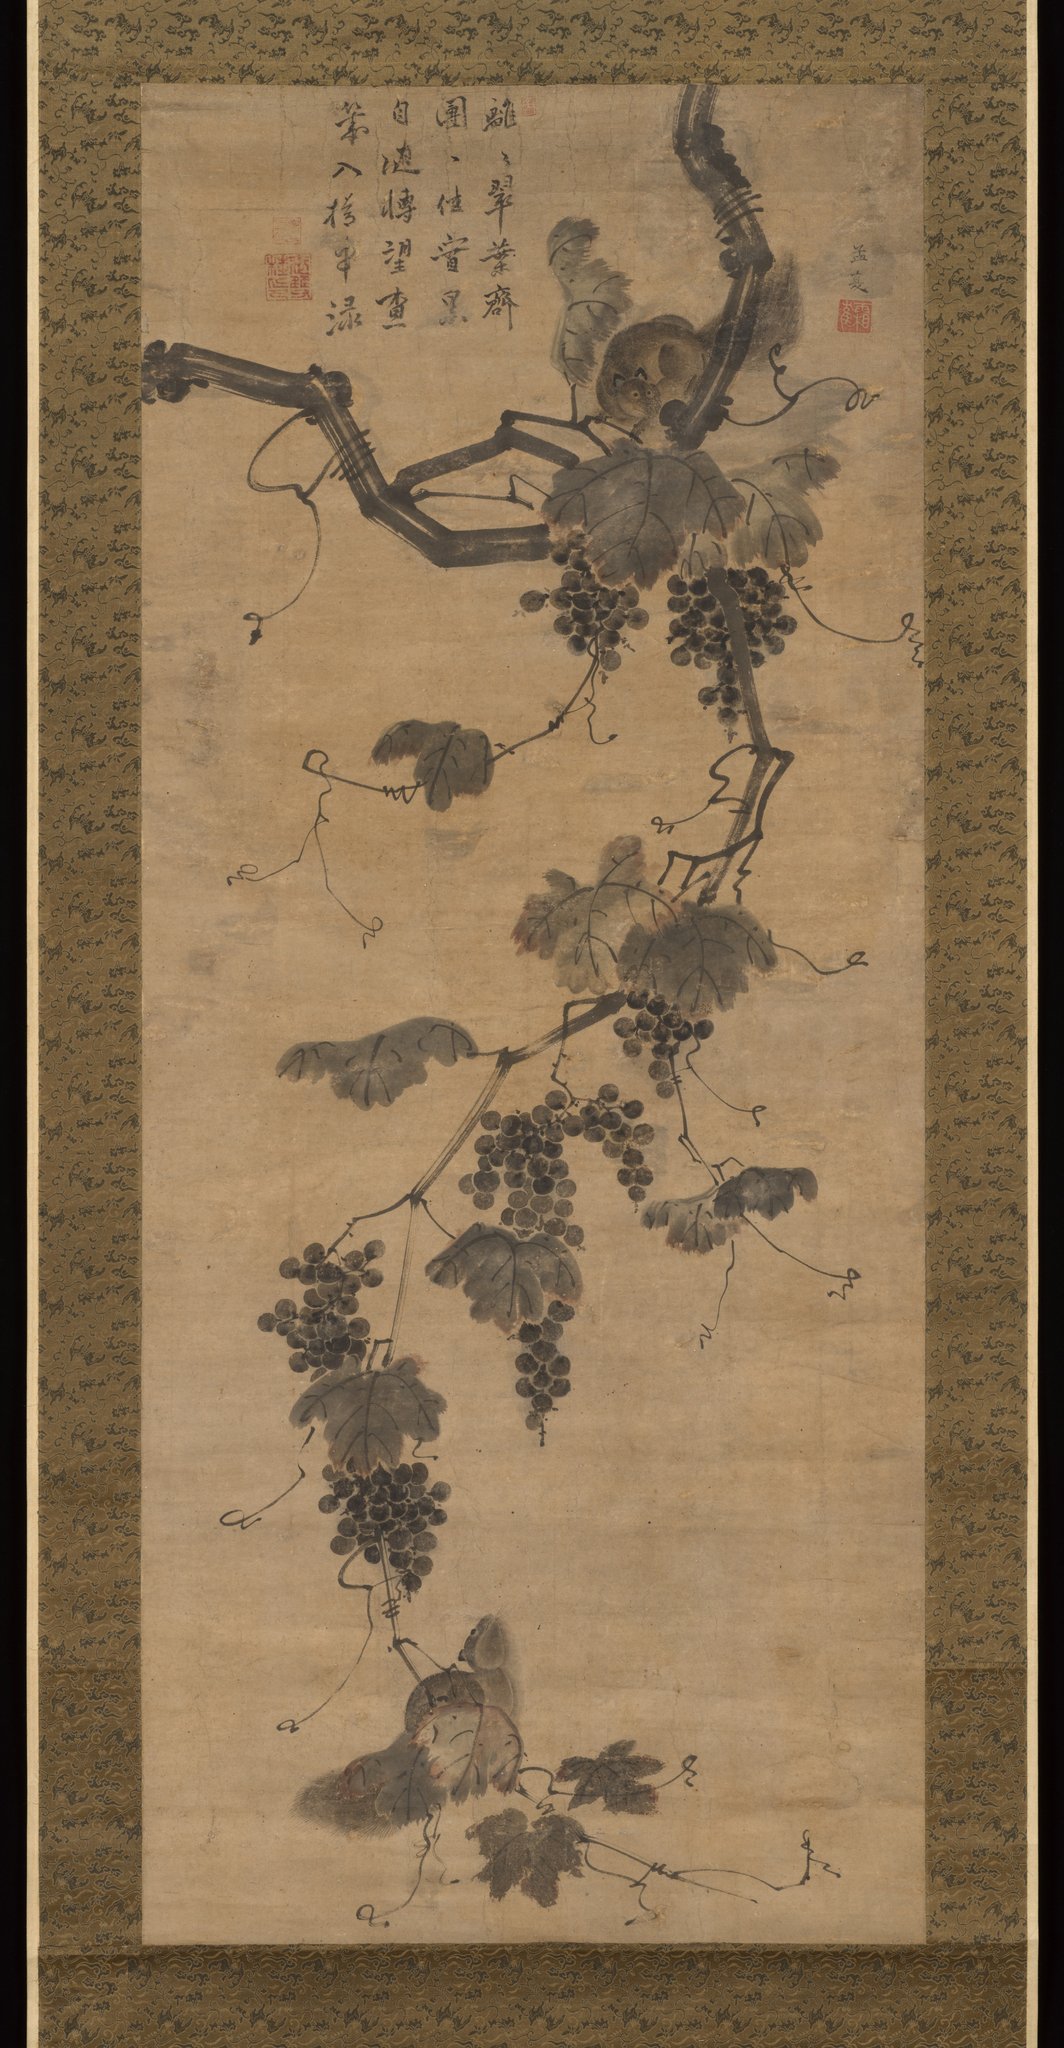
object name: hanging scroll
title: Grapevine and Squirrels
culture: korean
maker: unidentified artist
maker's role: artist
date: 1801-1833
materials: ink, paper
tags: grapes,squirrels,vines